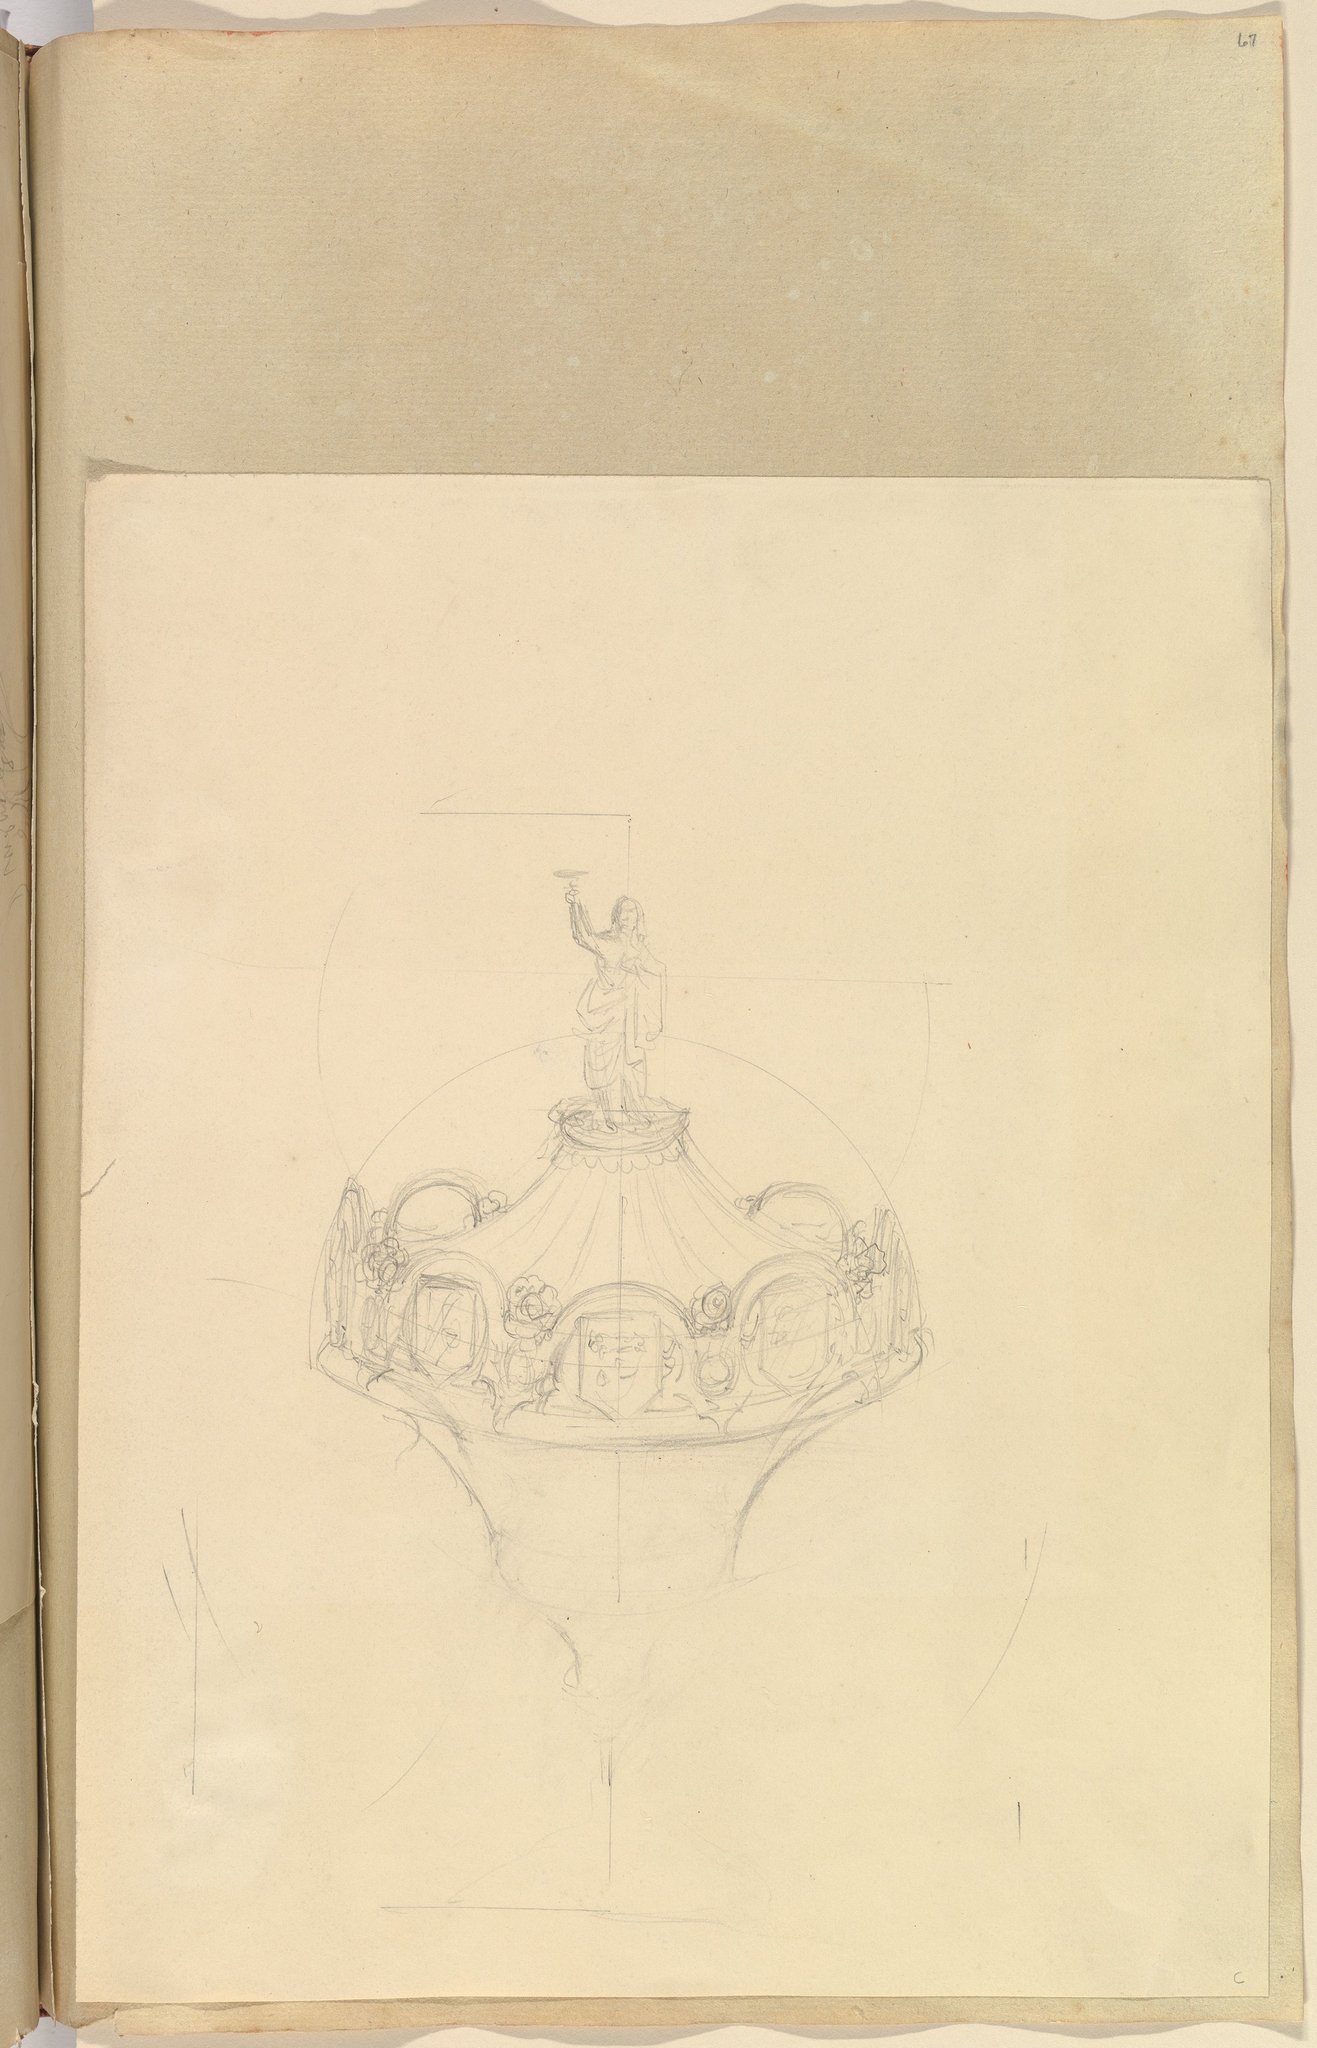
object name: drawing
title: Sketch of a Chalice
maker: alfred henry forrester [alfred crowquill]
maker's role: artist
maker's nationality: british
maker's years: 1804-1872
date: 1845-1855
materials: graphite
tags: chalices